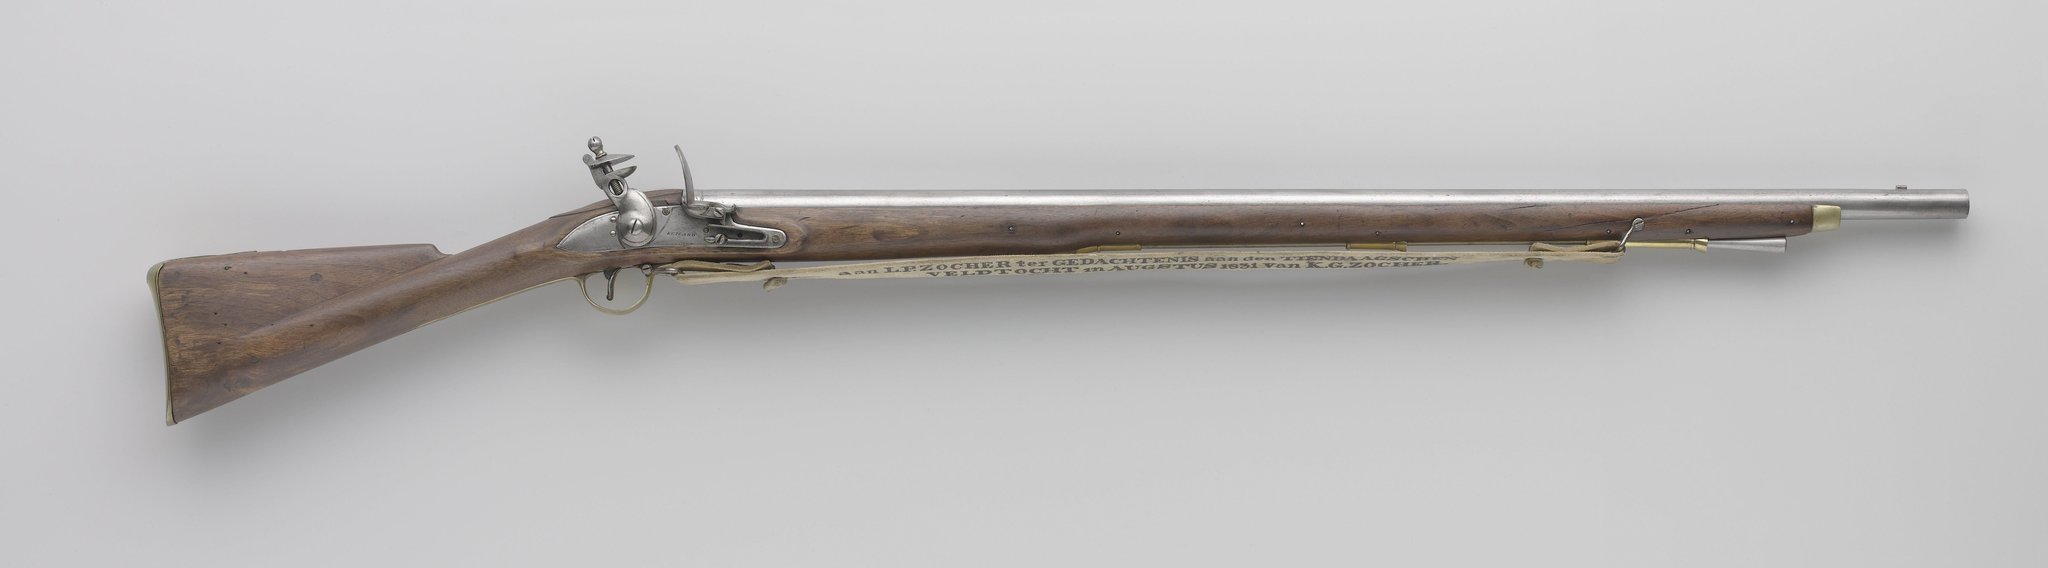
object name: rifle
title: Geweer van L.P. Zocher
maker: Anonymous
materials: iron, wood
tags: haarlem, louis paul zocher, belgium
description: Geweer met bajonet met draagriem met opschrift: Aan L.P. Zocher ter gedachtenis aan den Tiendaagschen Veldtocht in Augustus 1831 van K.G. Zocher.